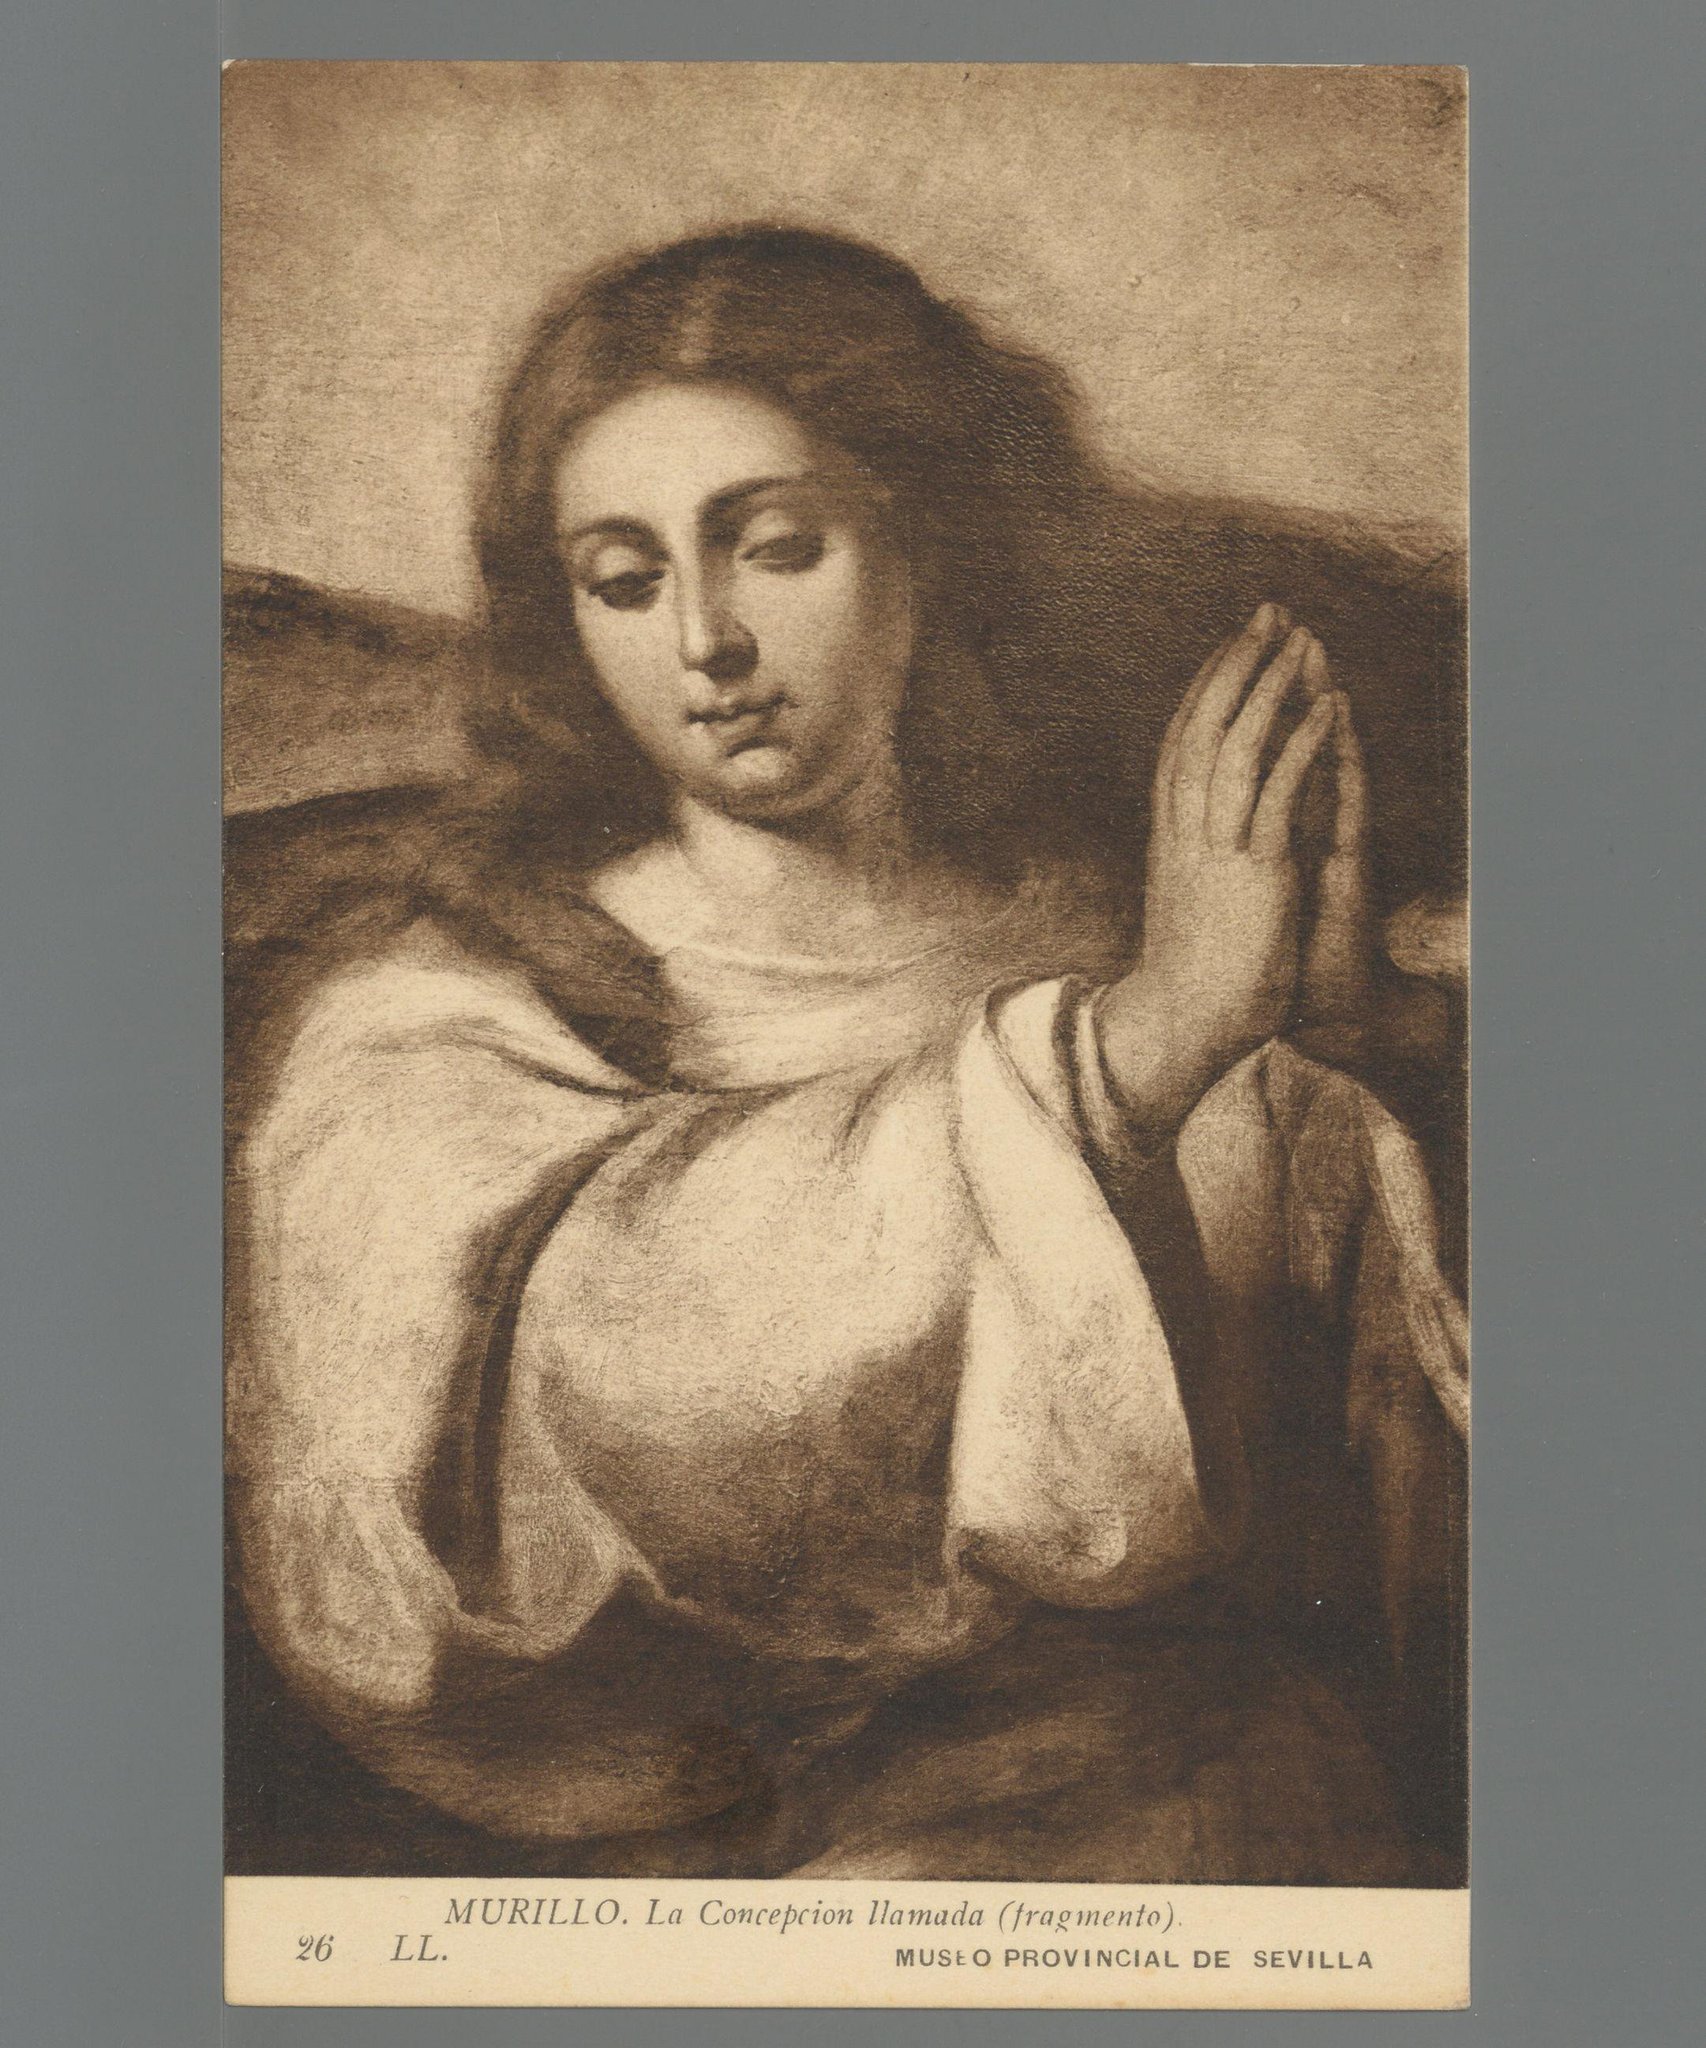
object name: reproduction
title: La Concepcion llamada (fragmento)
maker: bartolomé esteban murillo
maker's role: draughtsman, painter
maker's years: 1617-1682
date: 1905-1920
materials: cardboard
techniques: photograph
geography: paris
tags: mary (without the christ-child)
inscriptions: collector's mark: ‘AFE v S’